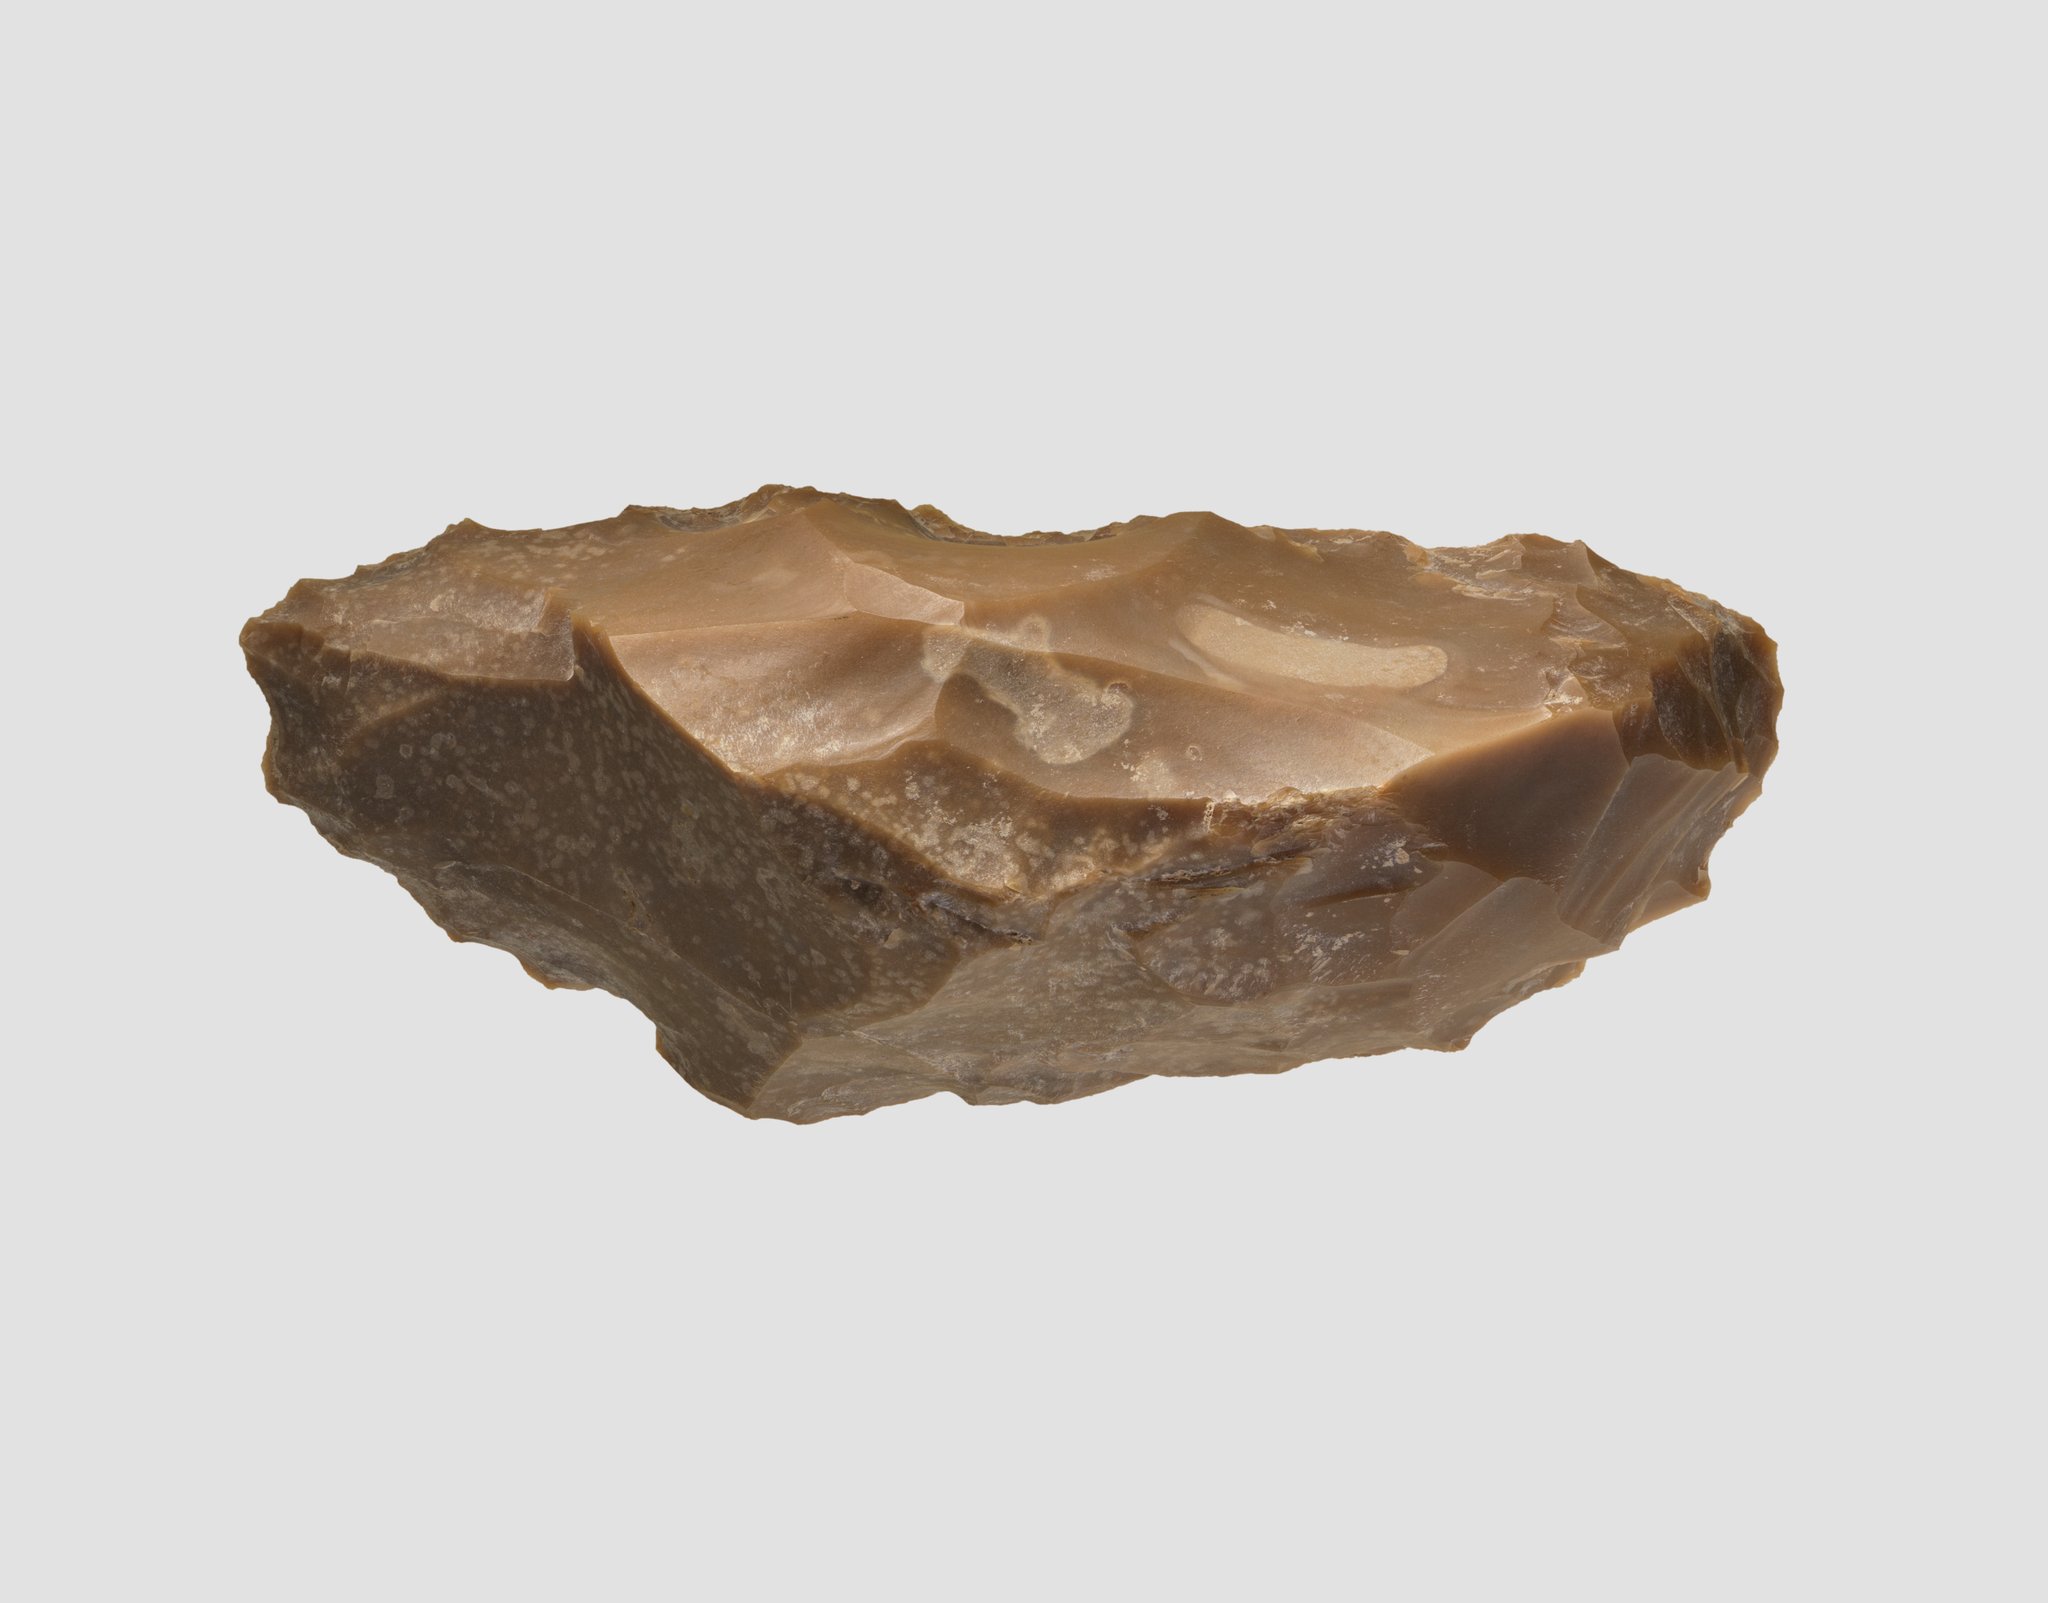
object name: scraper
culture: ghassulian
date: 4600-3600 BCE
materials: stone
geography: levant